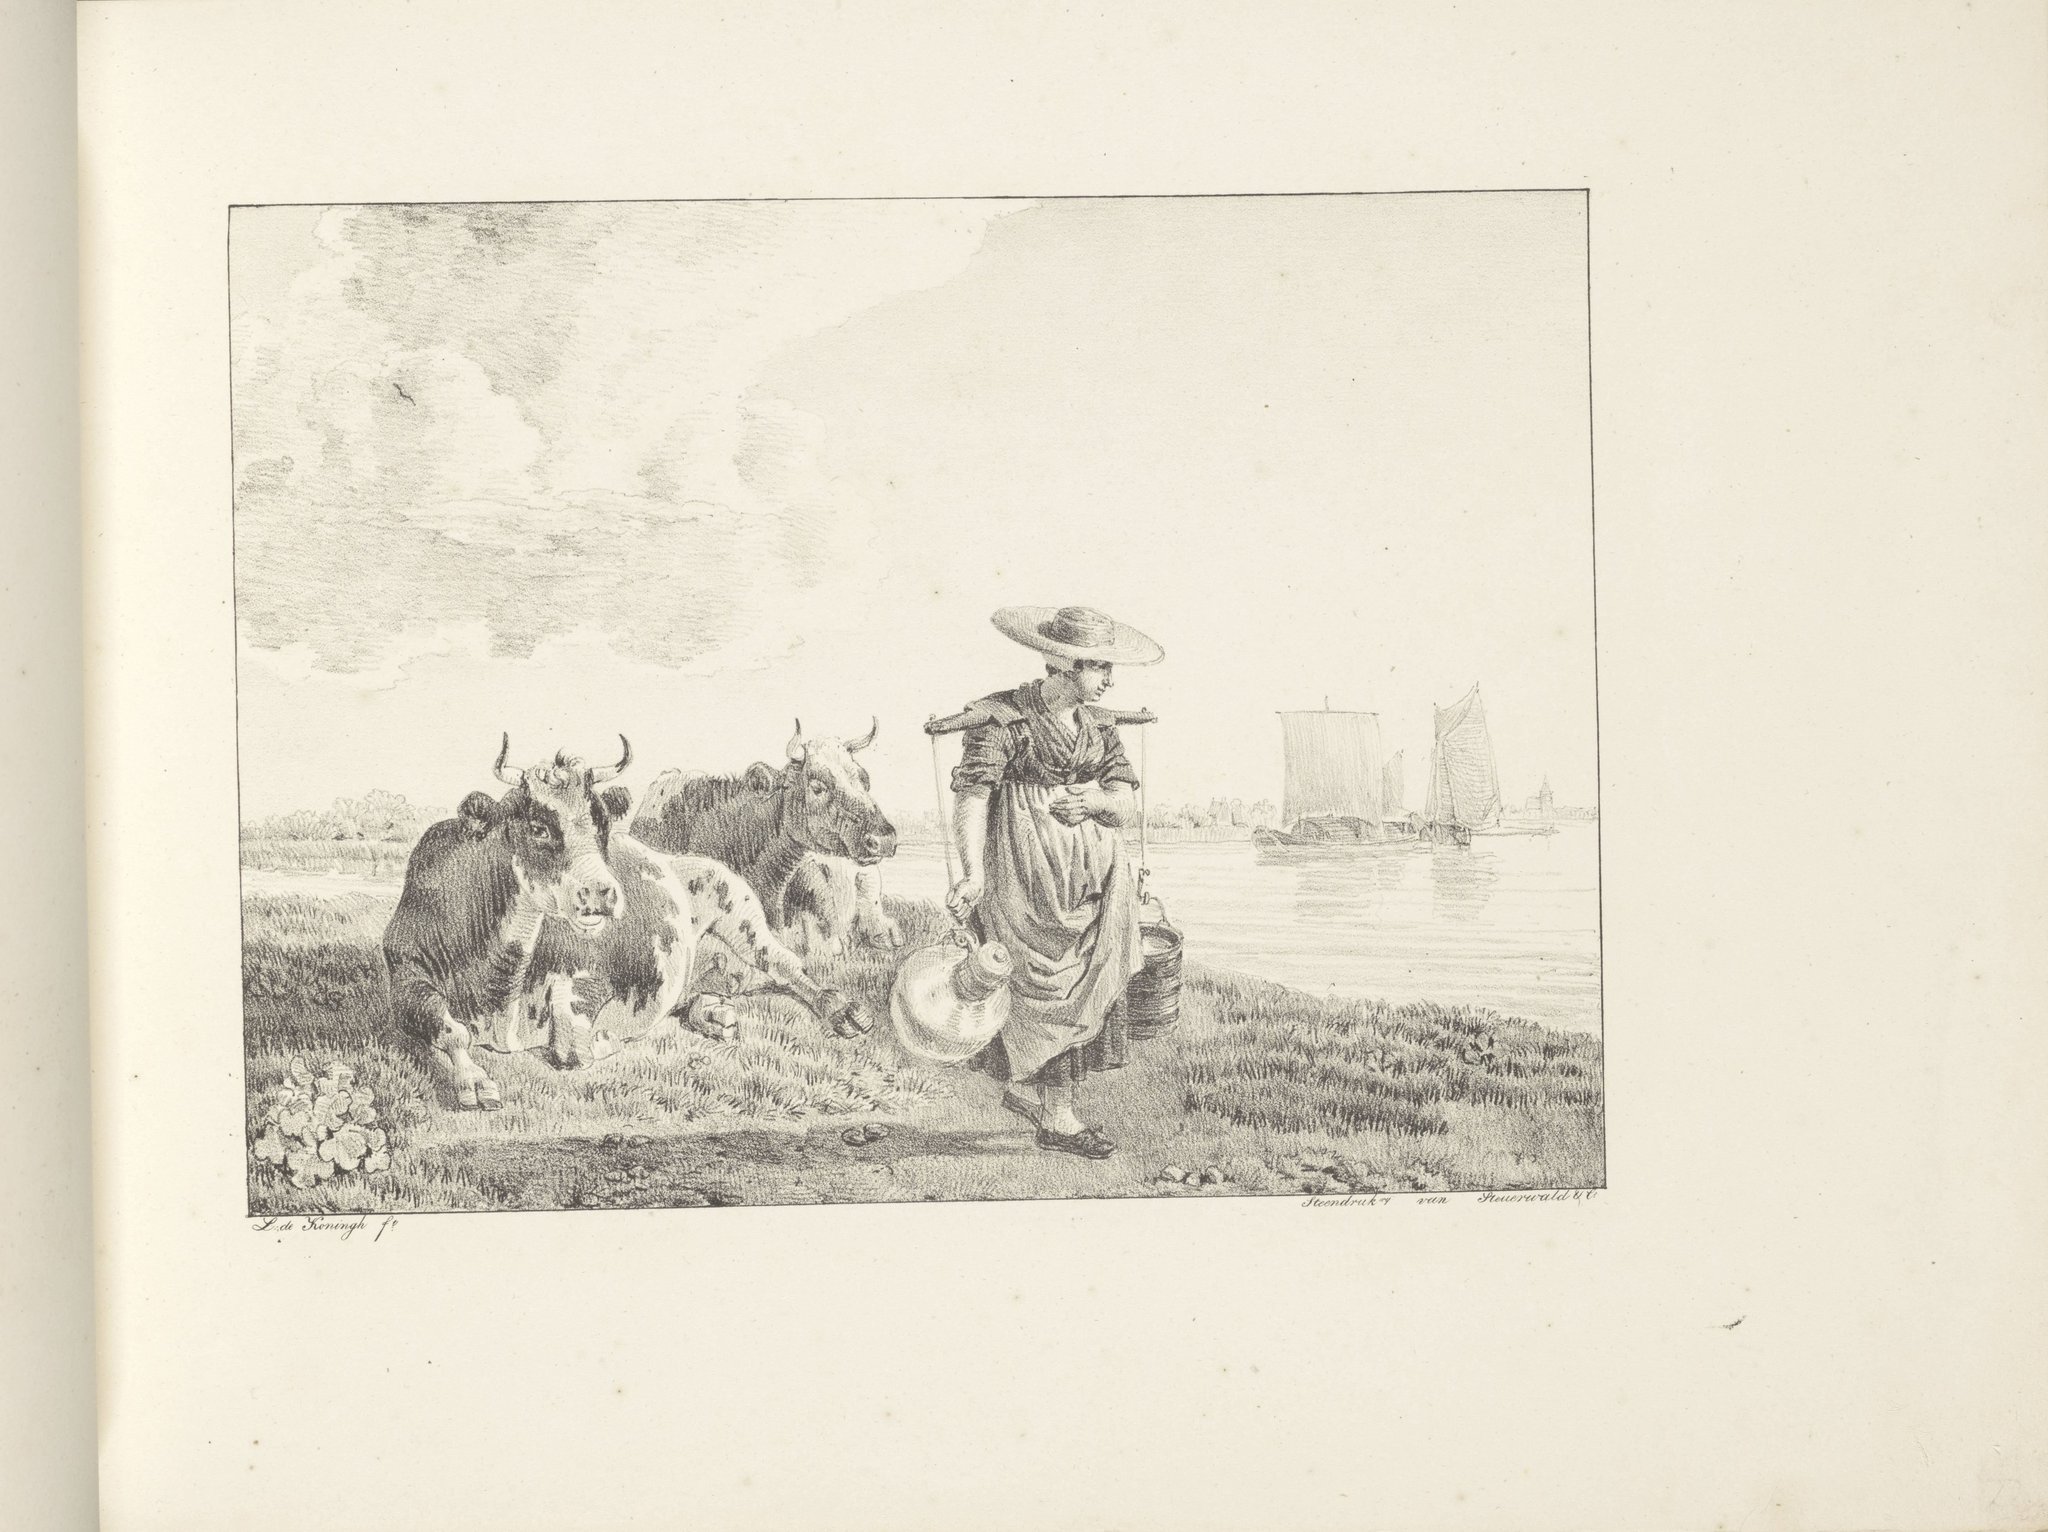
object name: print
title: Teekeningen naar Beesten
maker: leendert de koningh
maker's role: draughtsman, print maker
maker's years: 1777-1849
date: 1826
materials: paper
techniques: lithograph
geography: dordrecht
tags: cow, carrying something with yoke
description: De boerin draagt een juk met daaraan een emmer en een vat melk. Deze prent behoort tot een serie van zes prenten, samengebonden met een titelblad.